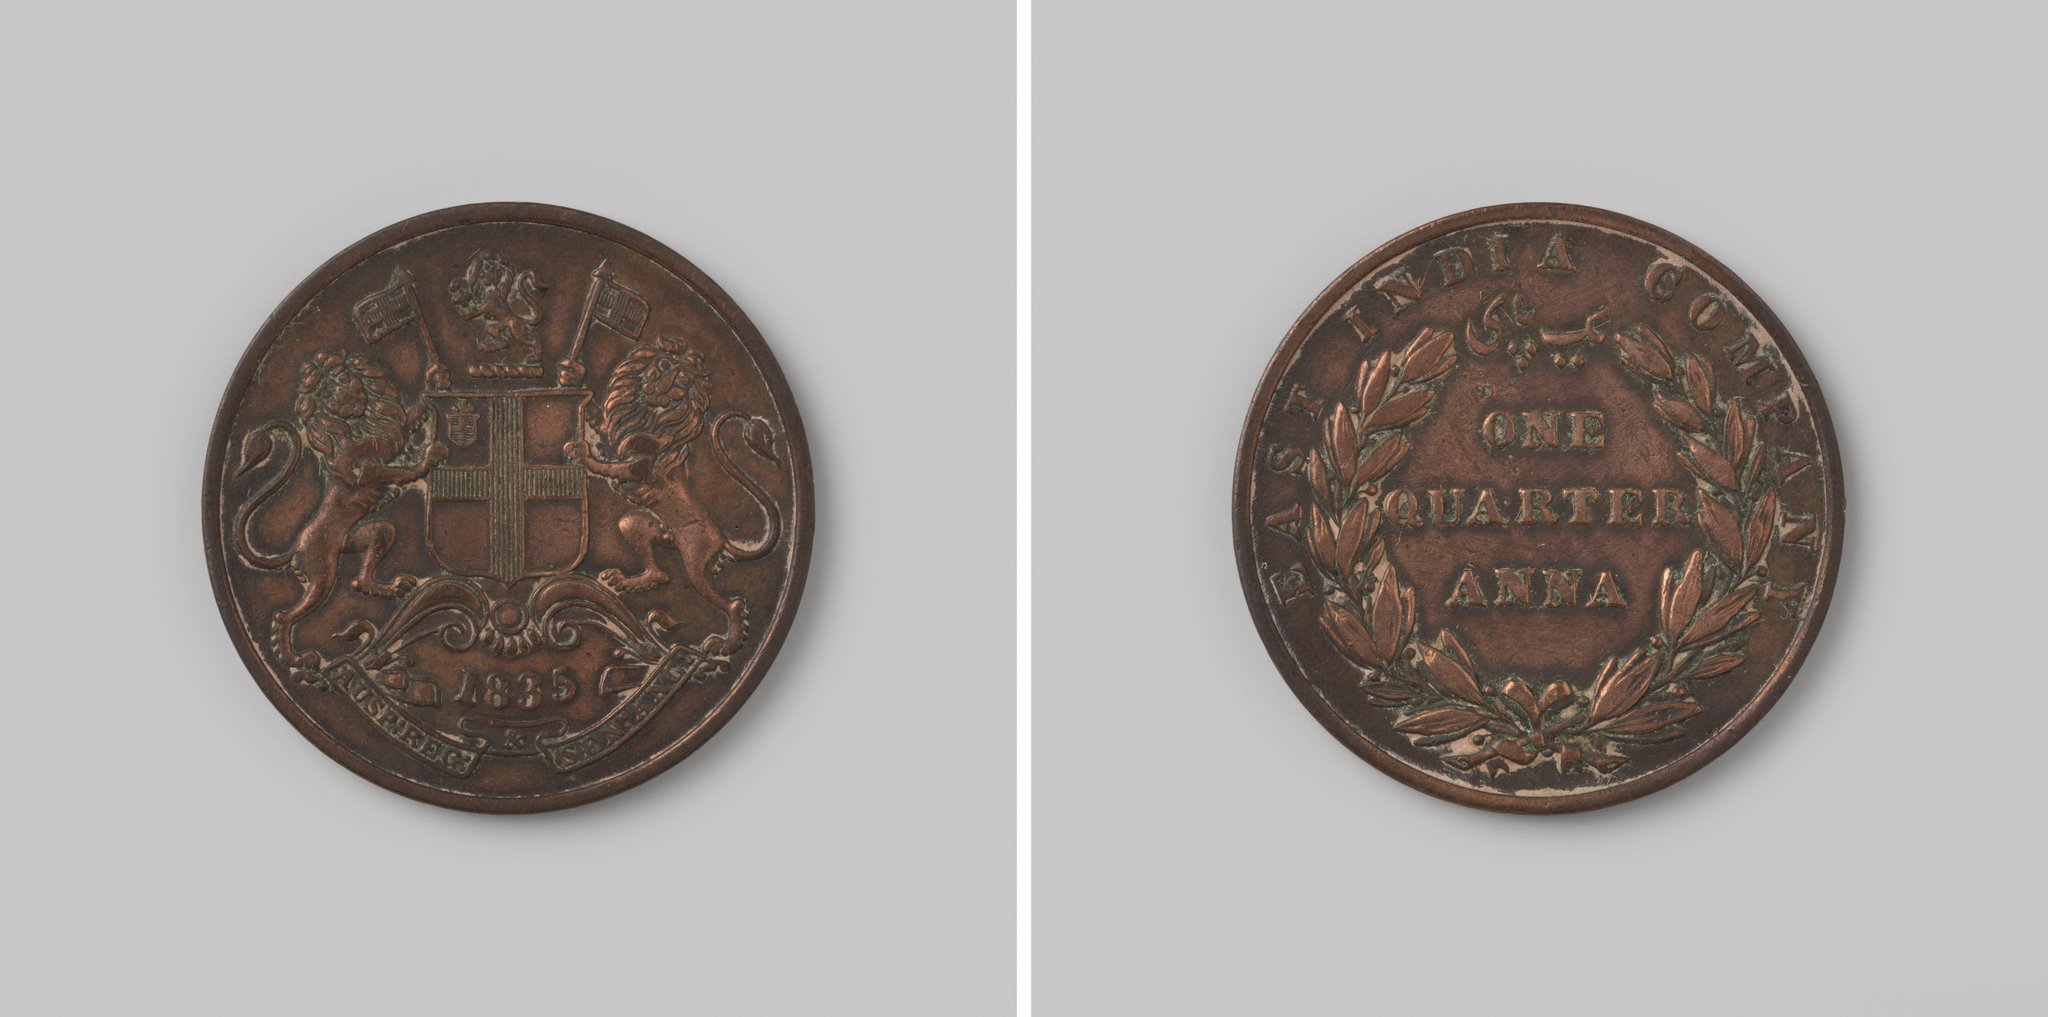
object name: coin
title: Engelse Oostindische Compagnie (EIC), India, 1/4 anna,1835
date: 1835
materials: copper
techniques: striking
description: Koperen munt. Voorzijde: door twee op banderol, waarin opschrift, staande leeuwen met pijl, waaraan vlag, in de klauw, gehouden wapenschild van de EIC, waarboven helmteken. Tussen wapenschild en banderol jaartal. Keerzijde: tussen twee samengebonden takken in drie regels waarde-aanduiding: one quarter anna, waarboven waarde-aanduiding in Arabische lettertekens. Gladde rand.